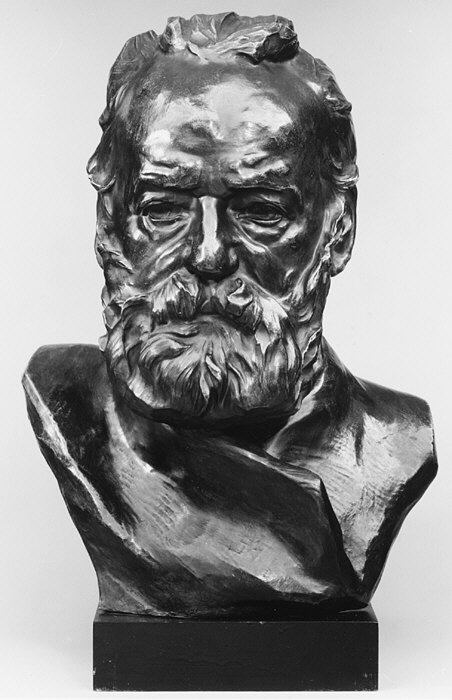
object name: bust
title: Victor Hugo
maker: auguste rodin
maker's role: artist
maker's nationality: french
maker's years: 1840-1917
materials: bronze, marble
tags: men,portraits